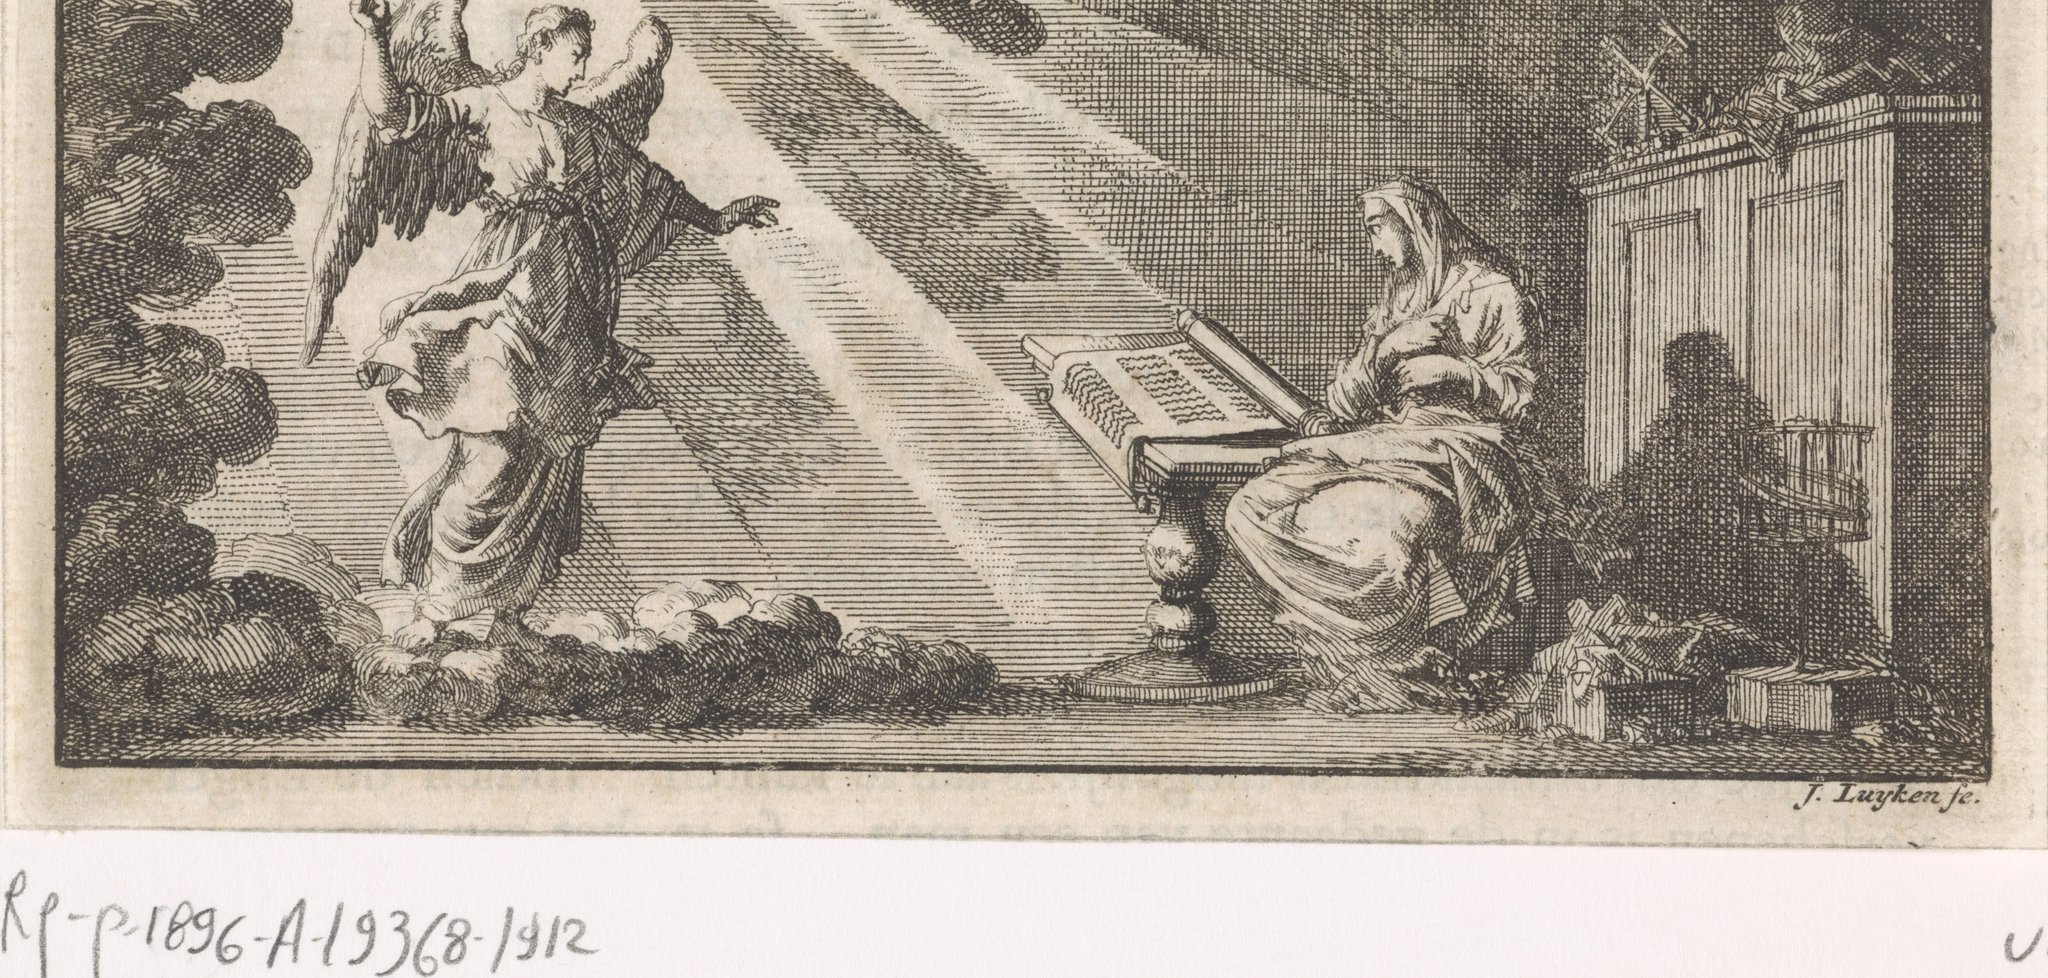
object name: print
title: Annunciatie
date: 1700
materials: paper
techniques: etching, letterpress printing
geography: amsterdam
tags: the annunciation: mary sitting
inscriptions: collector's mark: Lugt 2228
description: Boekillustratie voor Jeremy Taylor. Historie van't leven en de doot van onsen saligmaker Jesus Christus. Deel I. Amsterdam: Willem Broedelet, 1700, p. 1.